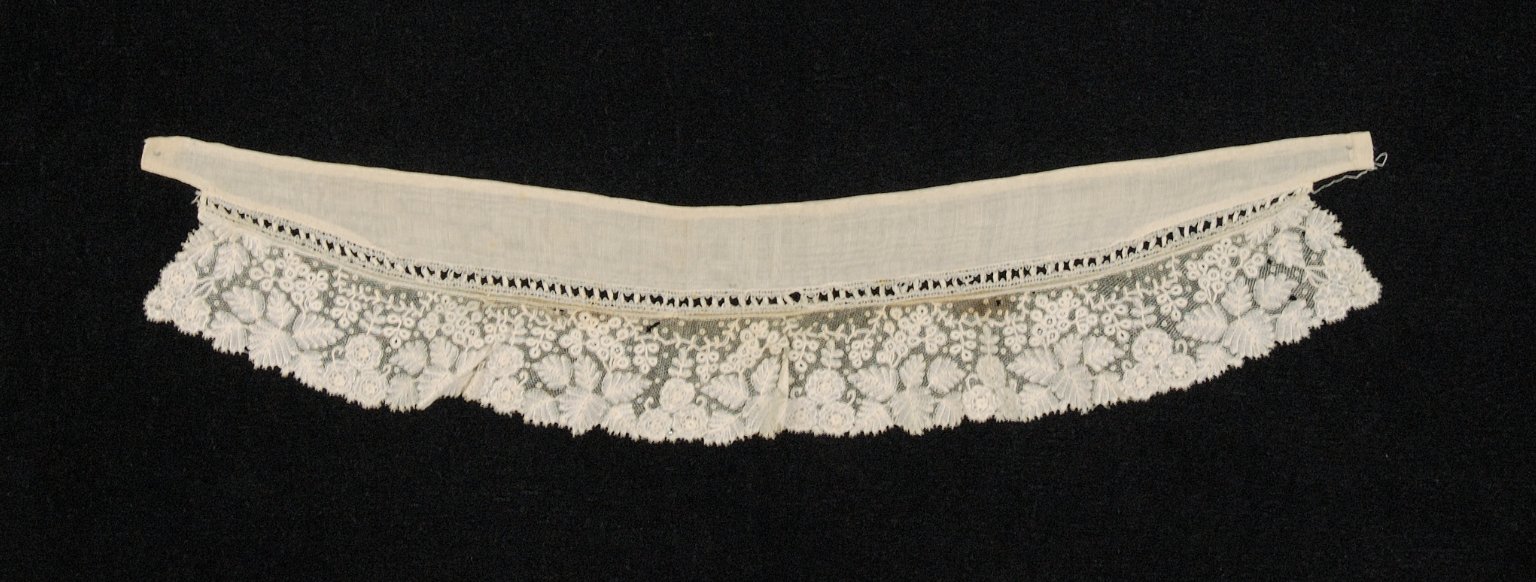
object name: collar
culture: belgian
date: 1850-1859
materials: cotton, linen